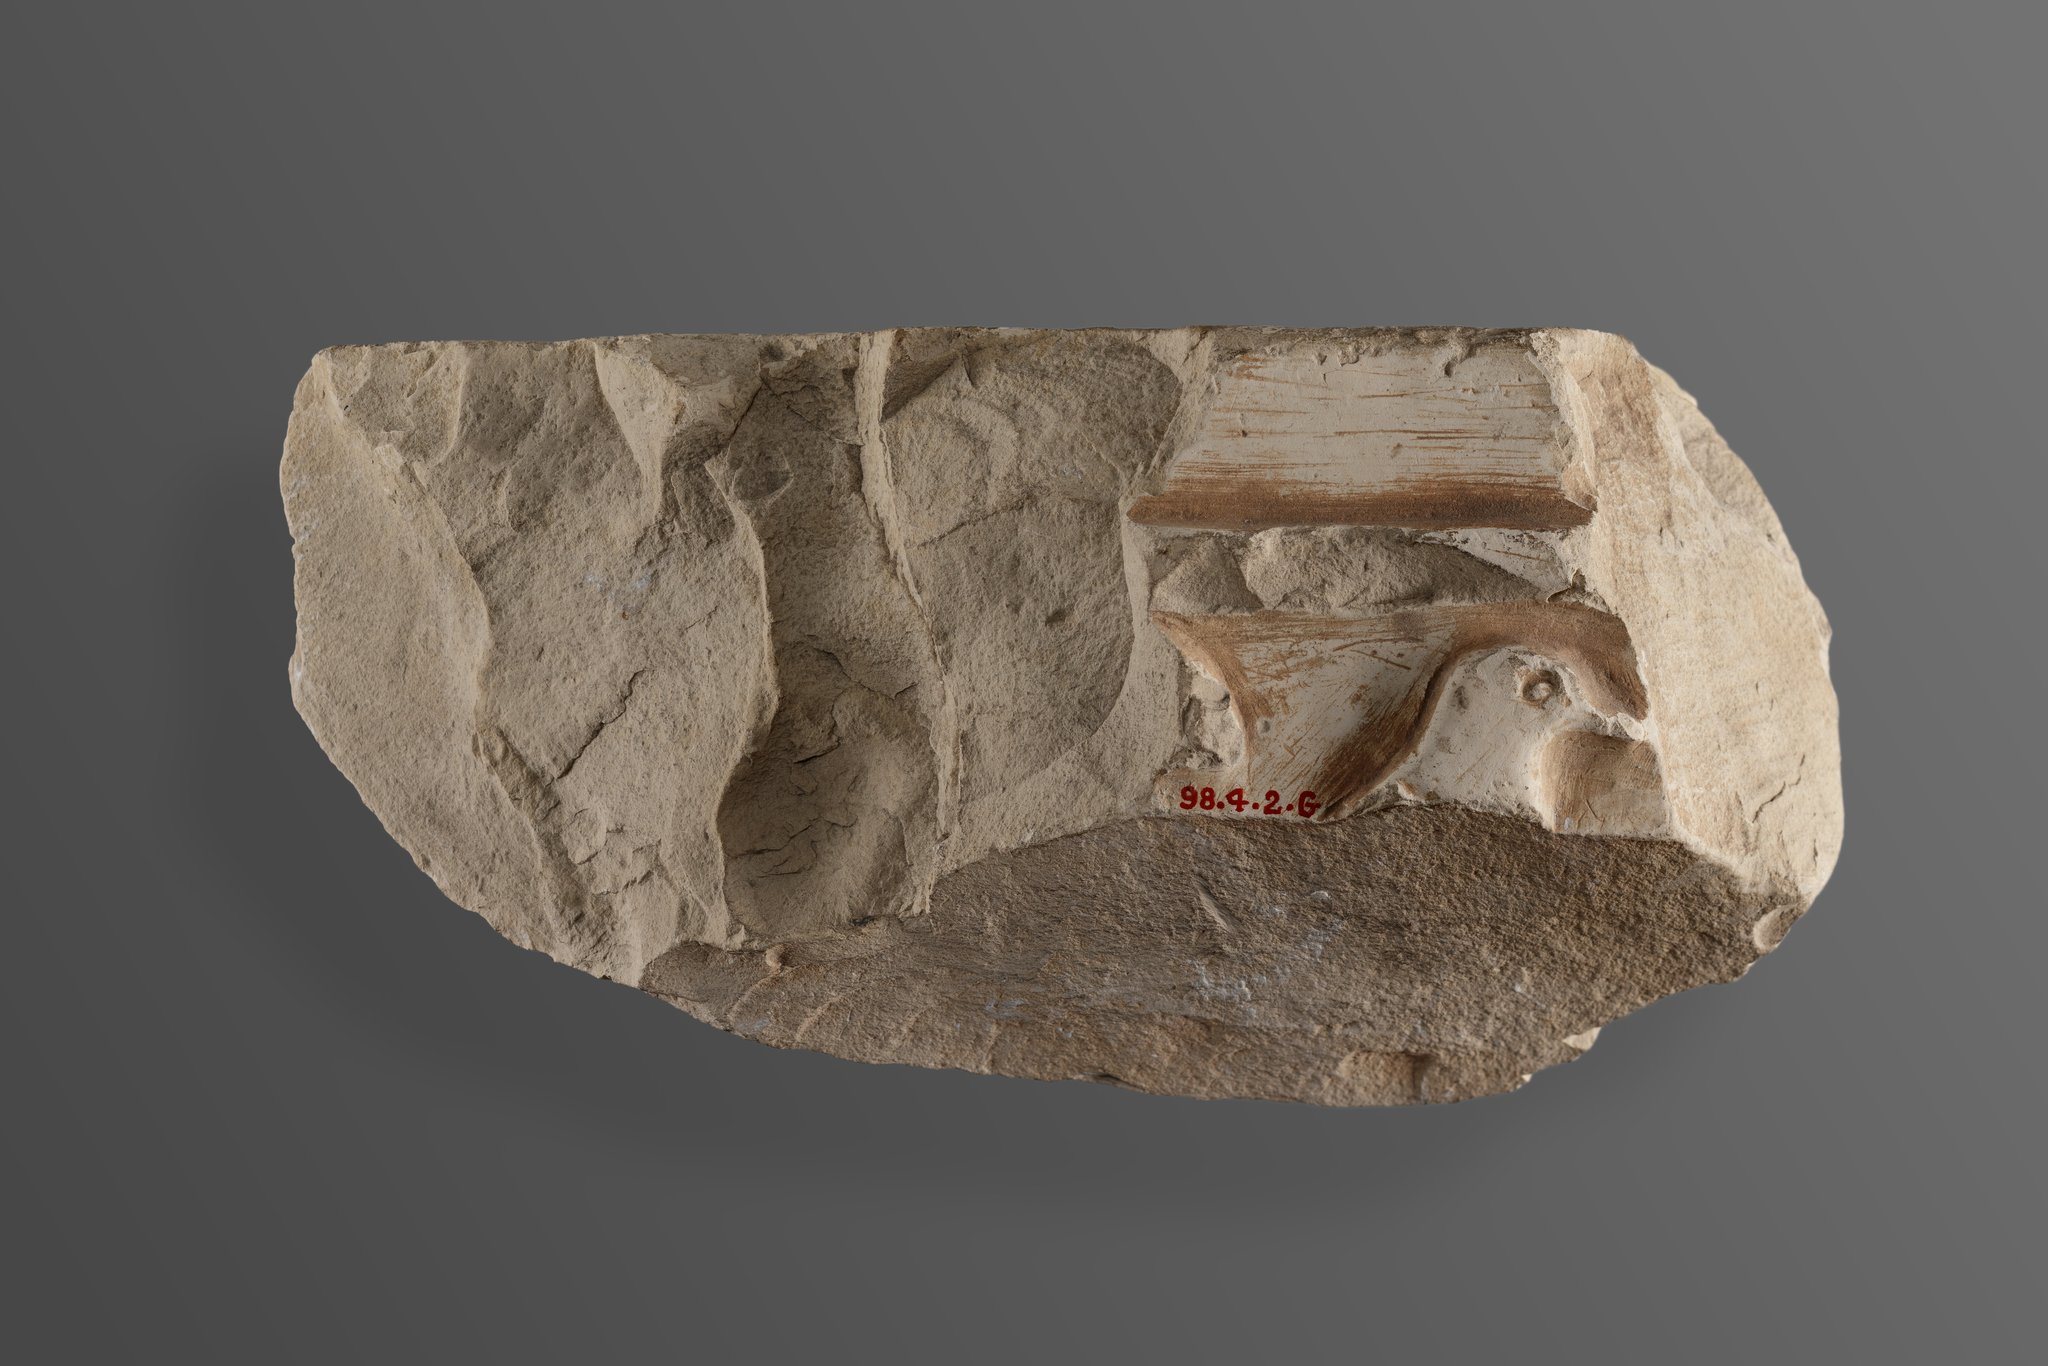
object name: relief fragment, tomb of mereri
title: Frieze from the tomb of Mereri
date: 2100-2030 BCE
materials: limestone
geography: egypt